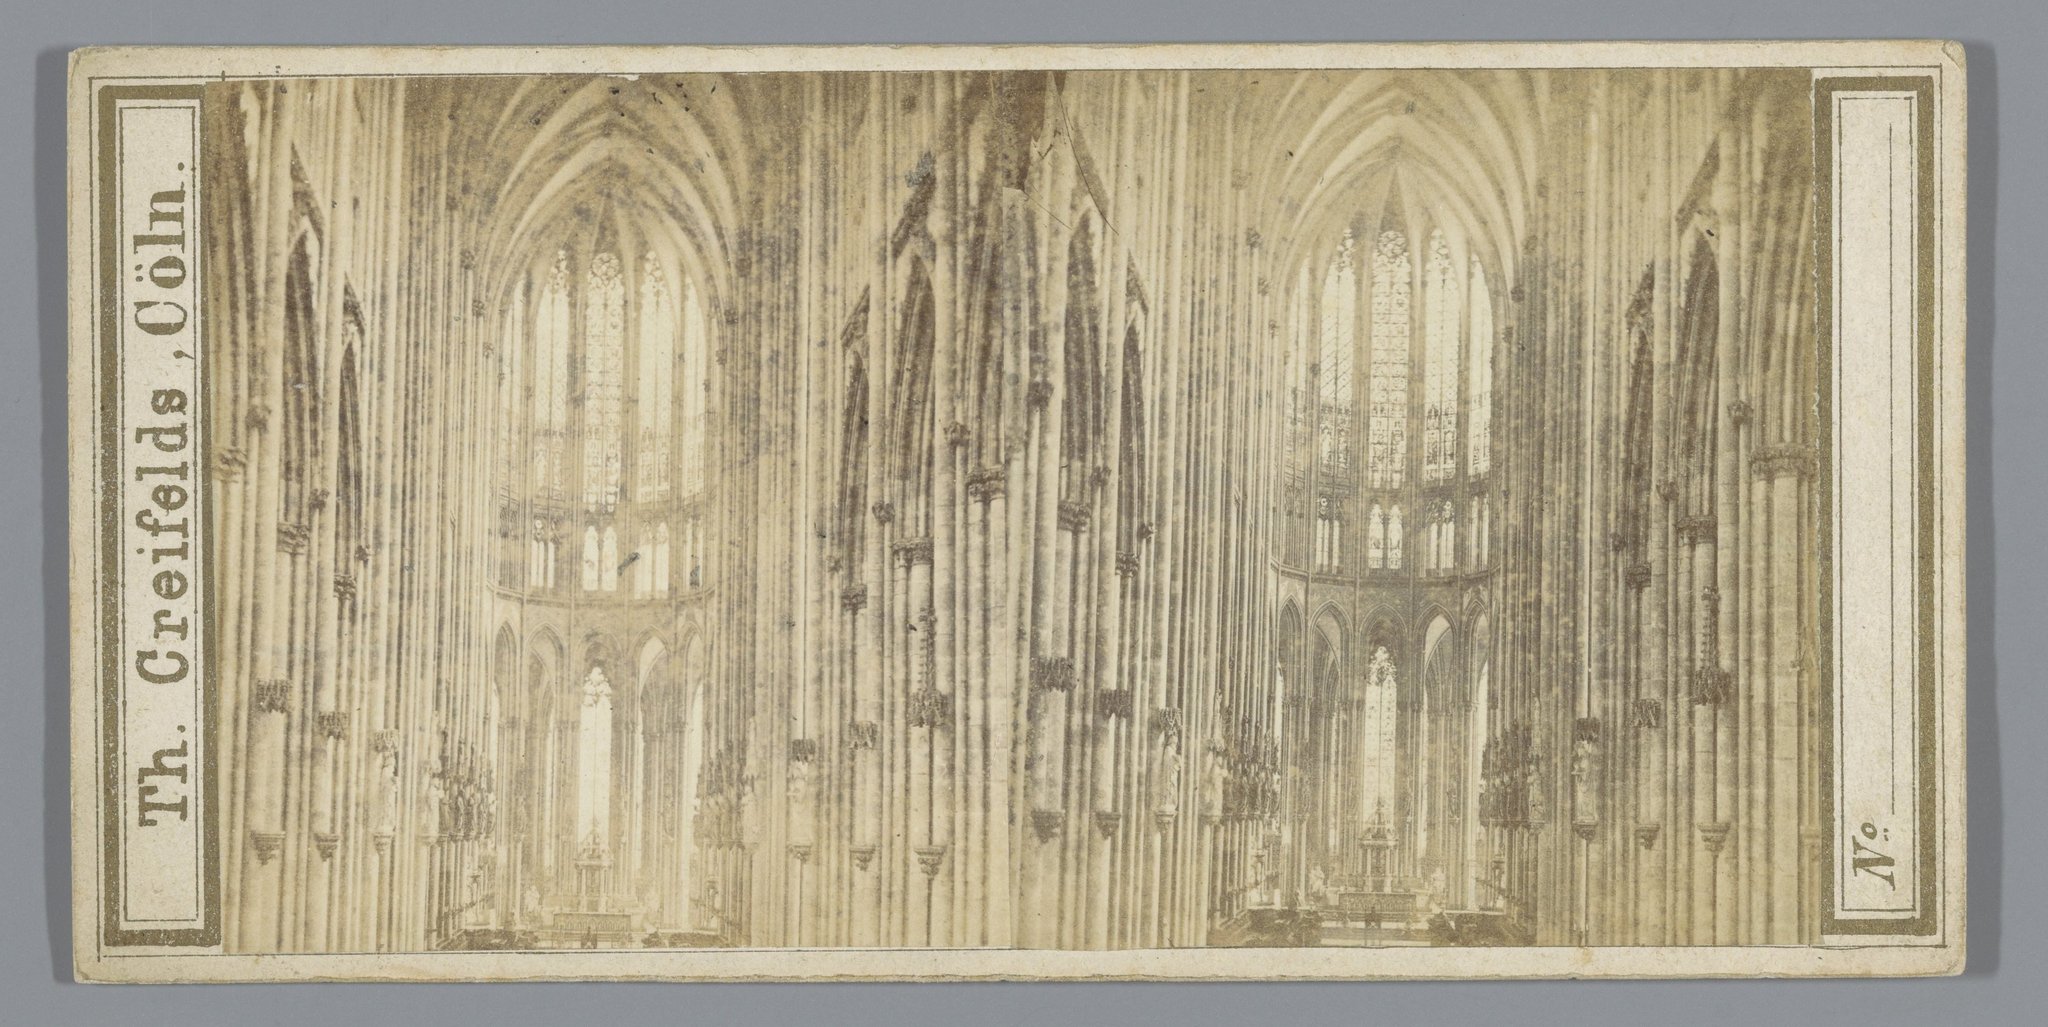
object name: stereograph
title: Interieur van de Dom van Keulen met zicht op het koor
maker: theodor creifelds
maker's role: publisher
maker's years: 1815-1875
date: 1860-1880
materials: cardboard, photographic support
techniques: albumen print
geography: cologne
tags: parts of church interior: choir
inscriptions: number: ‘Nro. 10.’